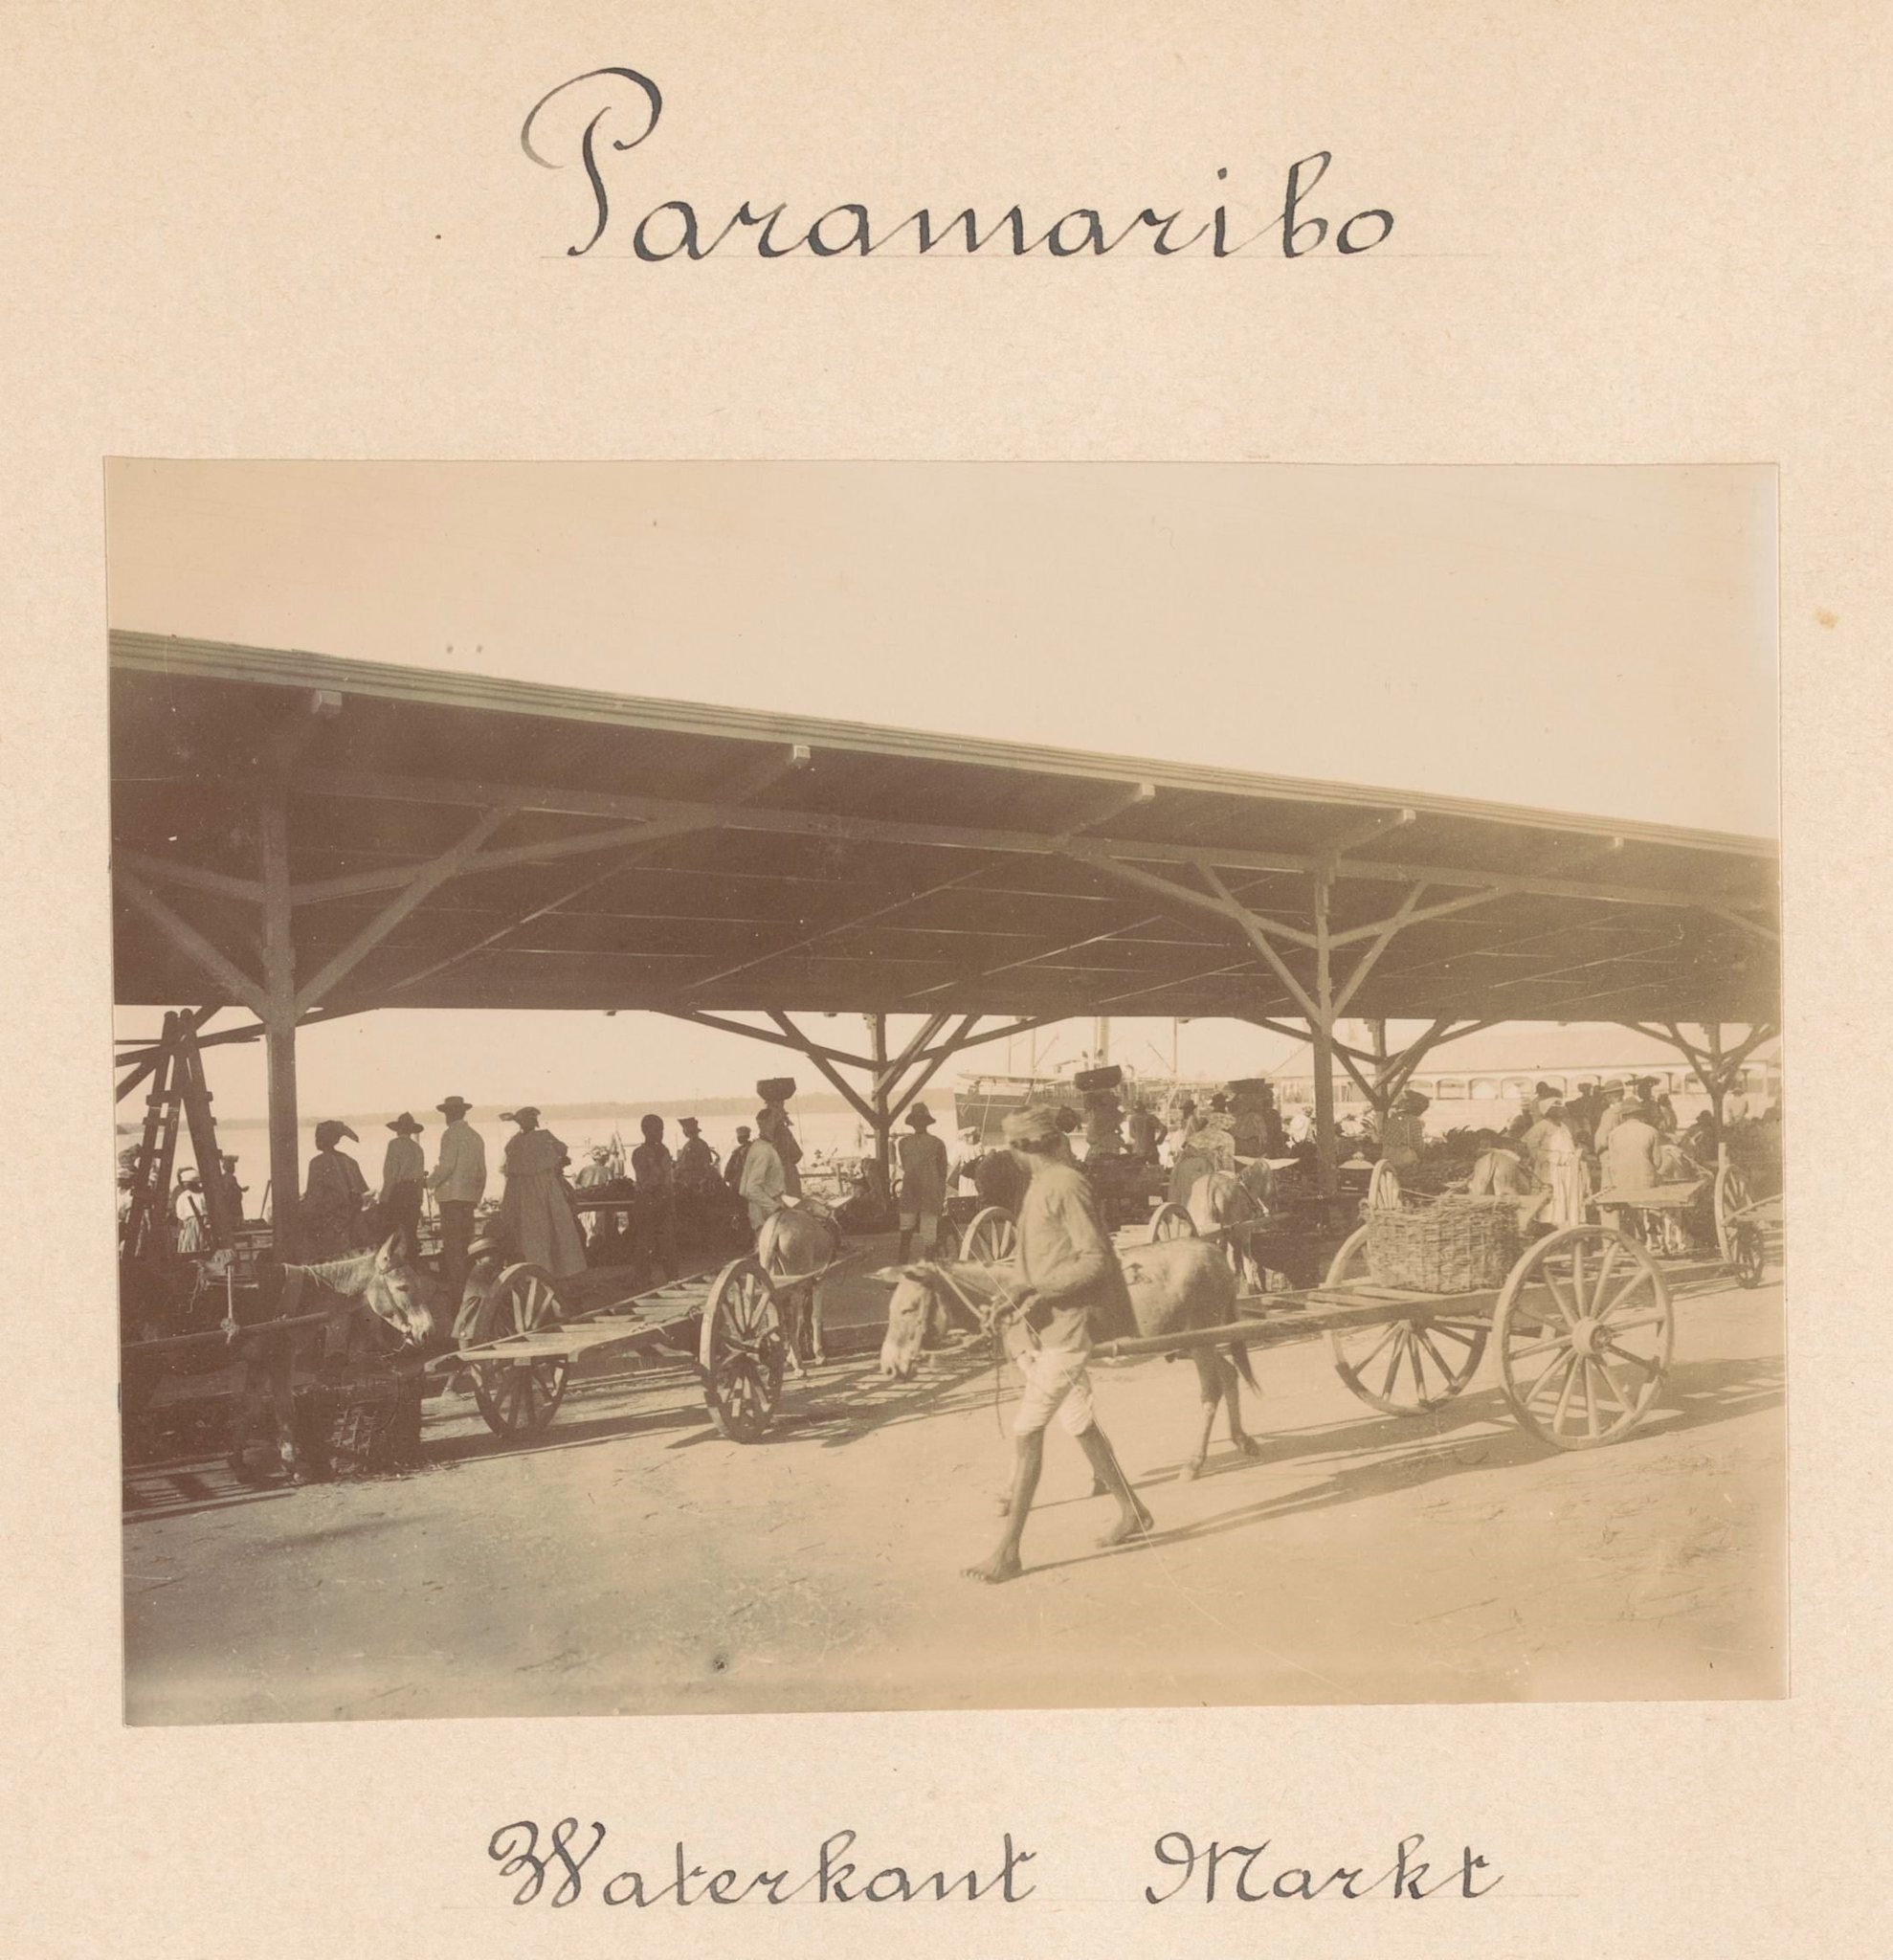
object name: photograph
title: Waterkant Markt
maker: eugen klein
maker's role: fotograaf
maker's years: 1869-1927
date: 1900-1905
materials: cardboard, photographic support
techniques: gelatin silver print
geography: paramaribo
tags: paramaribo (stad)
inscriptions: inscription: ‘Paramaribo / Waterkant Markt’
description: Een overdekte markt aan de Waterkant te Paramaribo. Onderdeel van een groep van 44 foto's van Paramaribo, Suriname en Curaçao, ca. 1900-1905, opgeplakt op kartons en voorzien van opschriften.